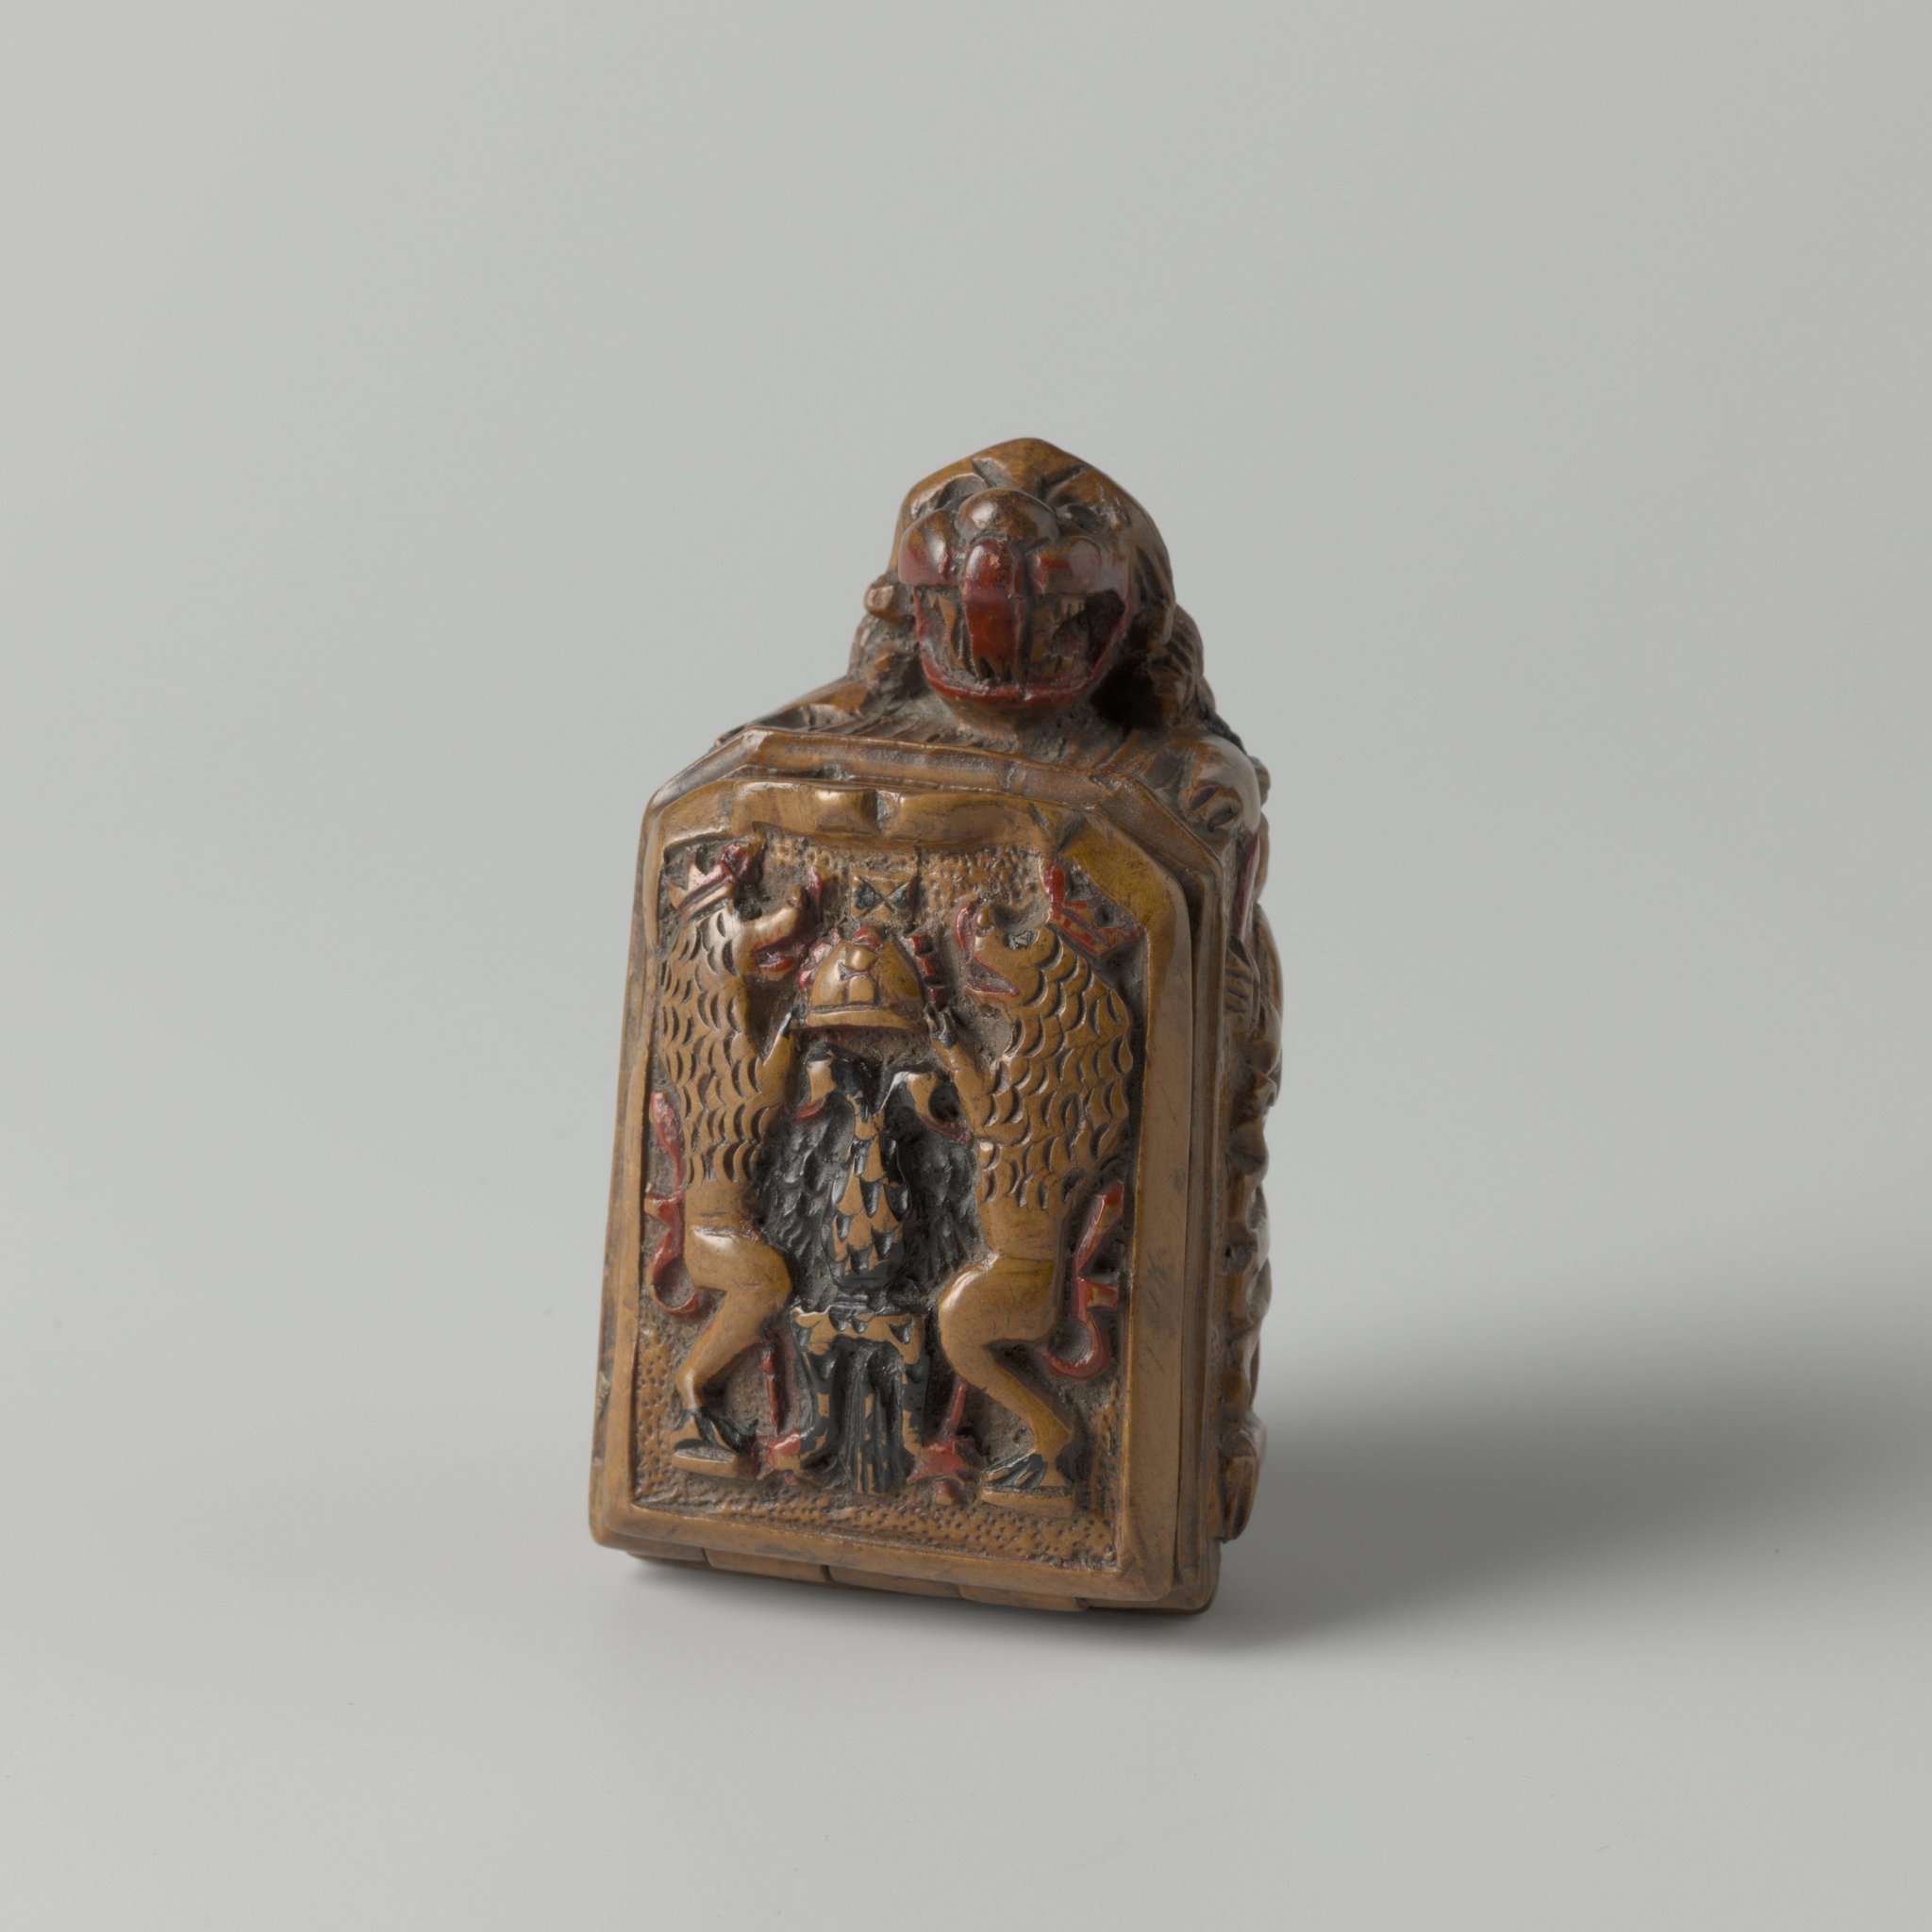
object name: box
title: Doos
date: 1700-1800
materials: wood, paint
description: Doosje van buxushout in de vorm van een leeuw waarbij een draak en een engel die een wapenschild vasthouden waarop een gekroonde adelaar en twee leeuwen (Arnhem?). In de deksel een spiegeltje.